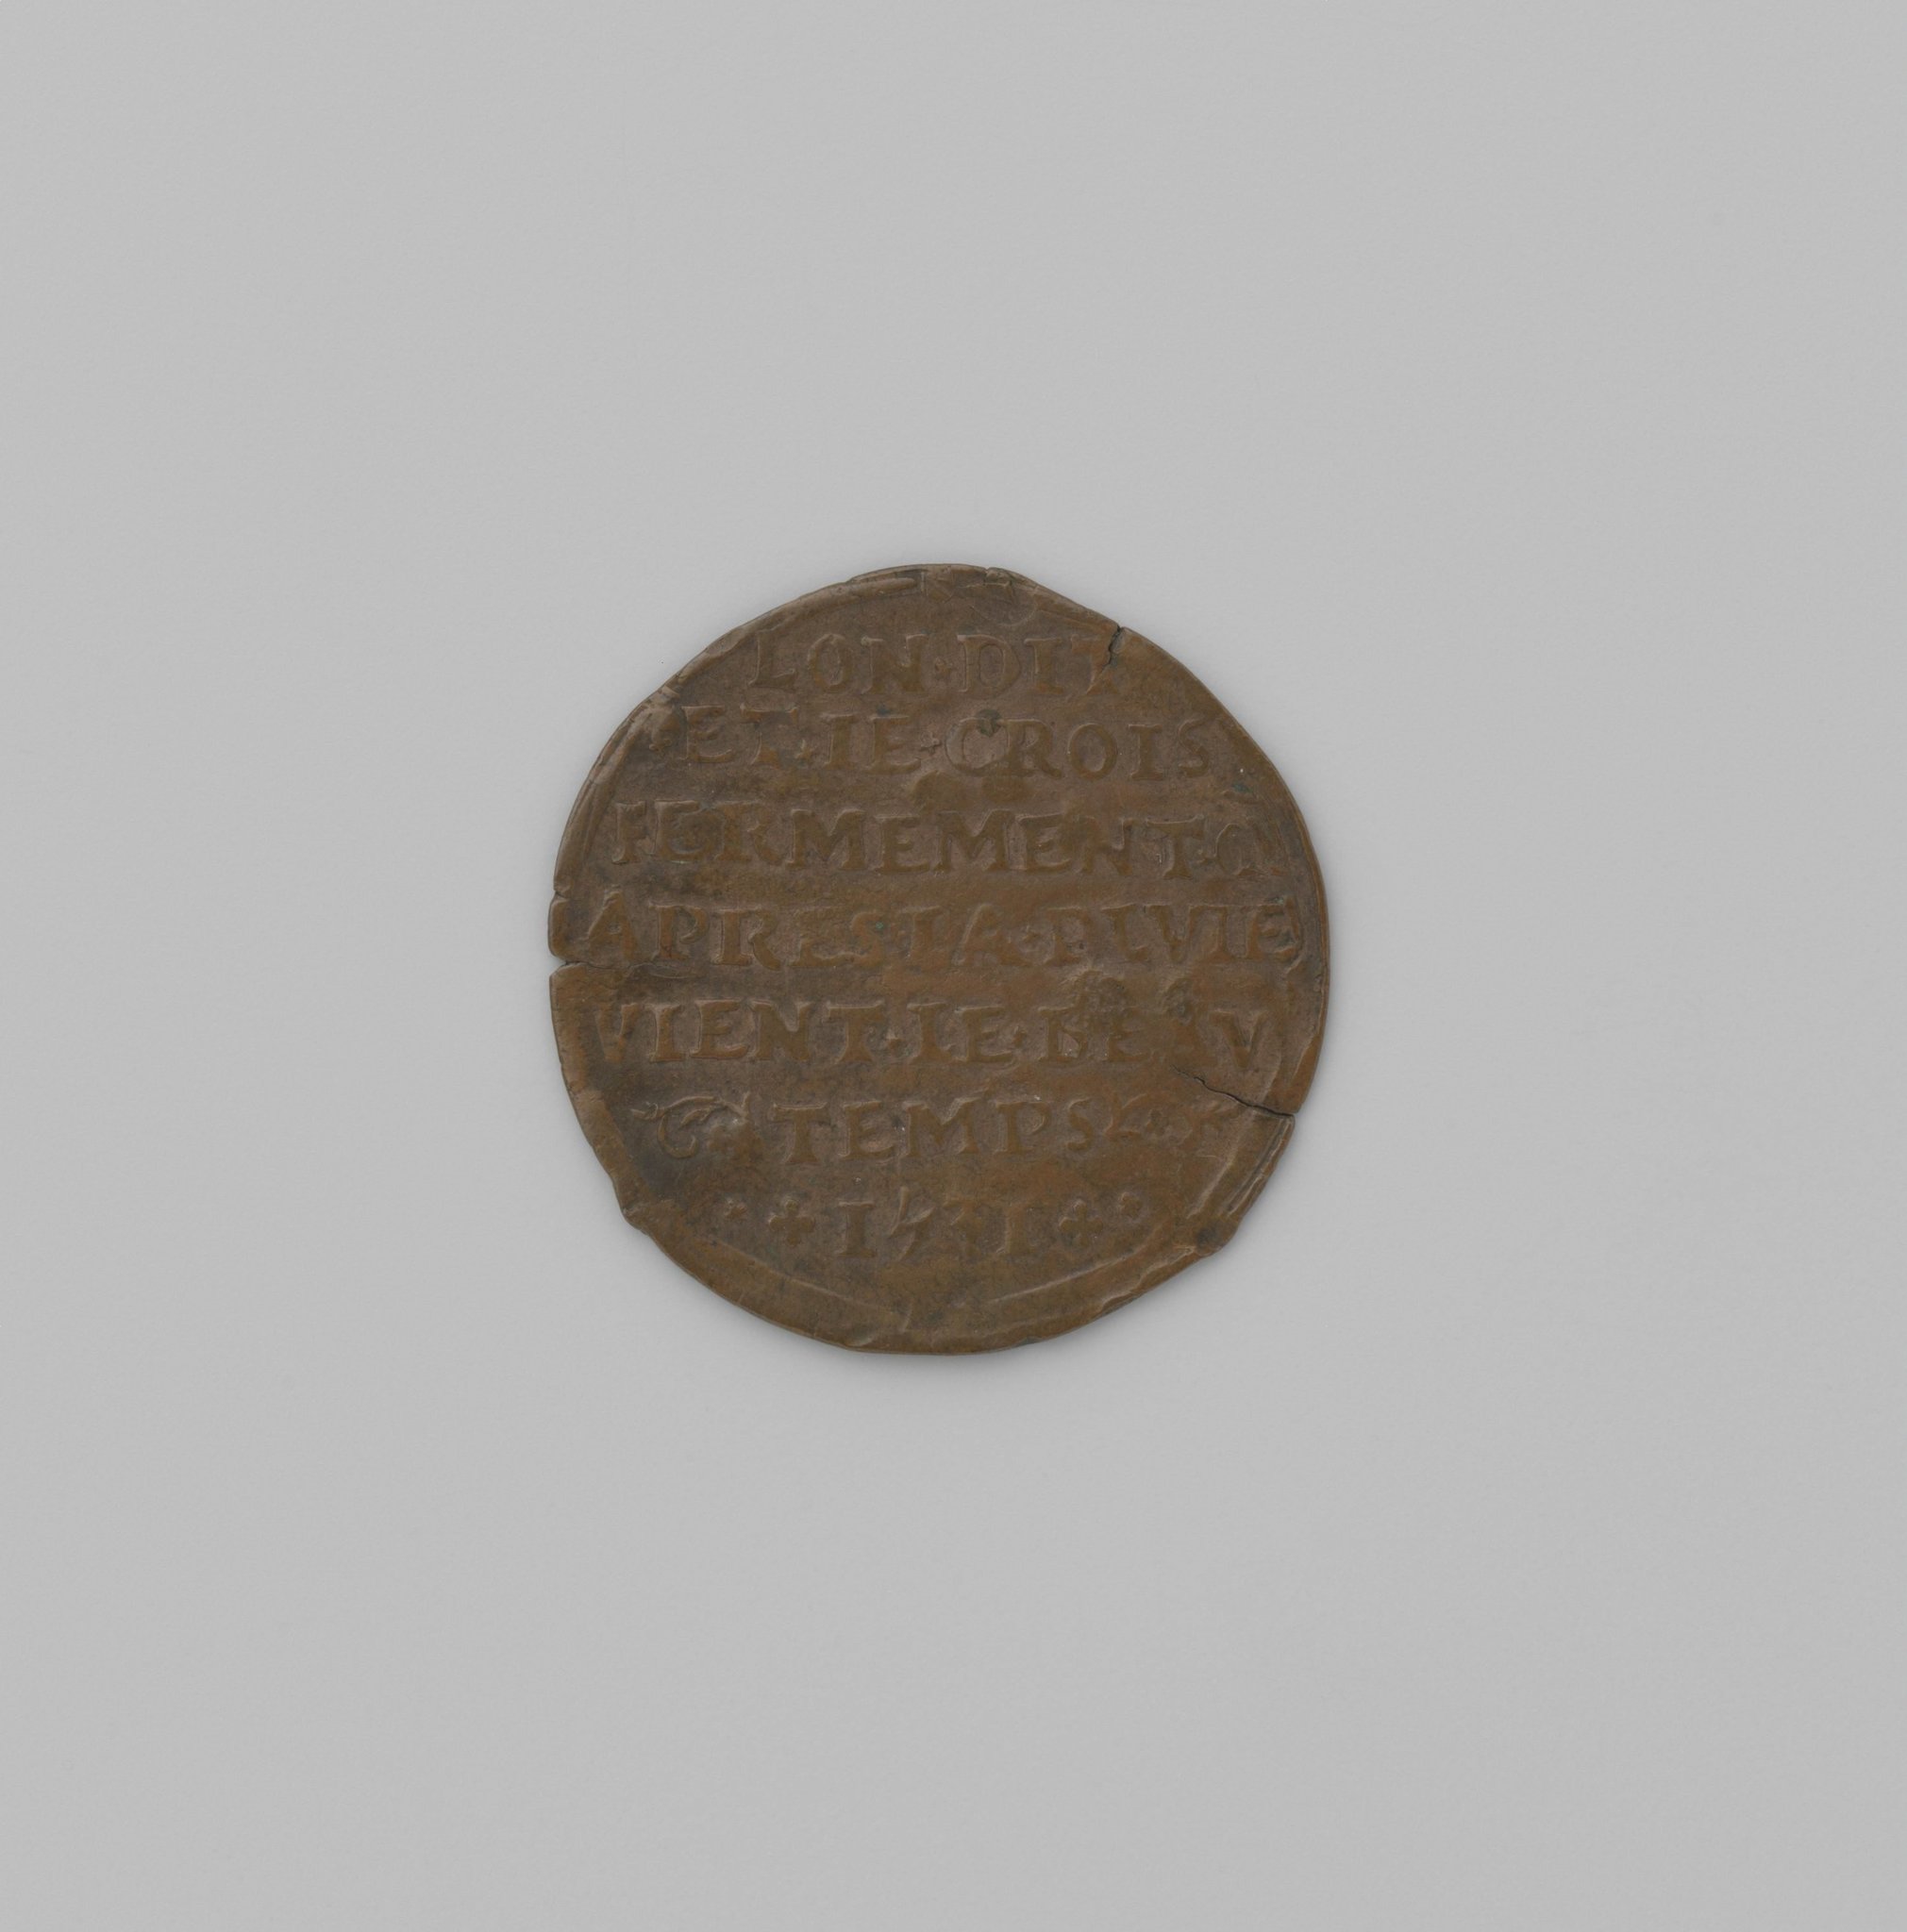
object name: jeton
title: The Great Zeeland Flood of 1531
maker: Anonymous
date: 1531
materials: copper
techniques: striking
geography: netherlands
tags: zeeland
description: Flood Disaster Medals. Much of the Netherlands lies below sea level. The threat of flooding is thus ever-present. Dikes, dams and polders were created to control the water. Still, these safety measures sometimes failed. Each century witnessed disastrous floods, with levees breaching and the countryside being inundated. The North Sea Flood of 1953 led to the construction of the Delta Works. Thanks to this major intervention the country has since remained dry.